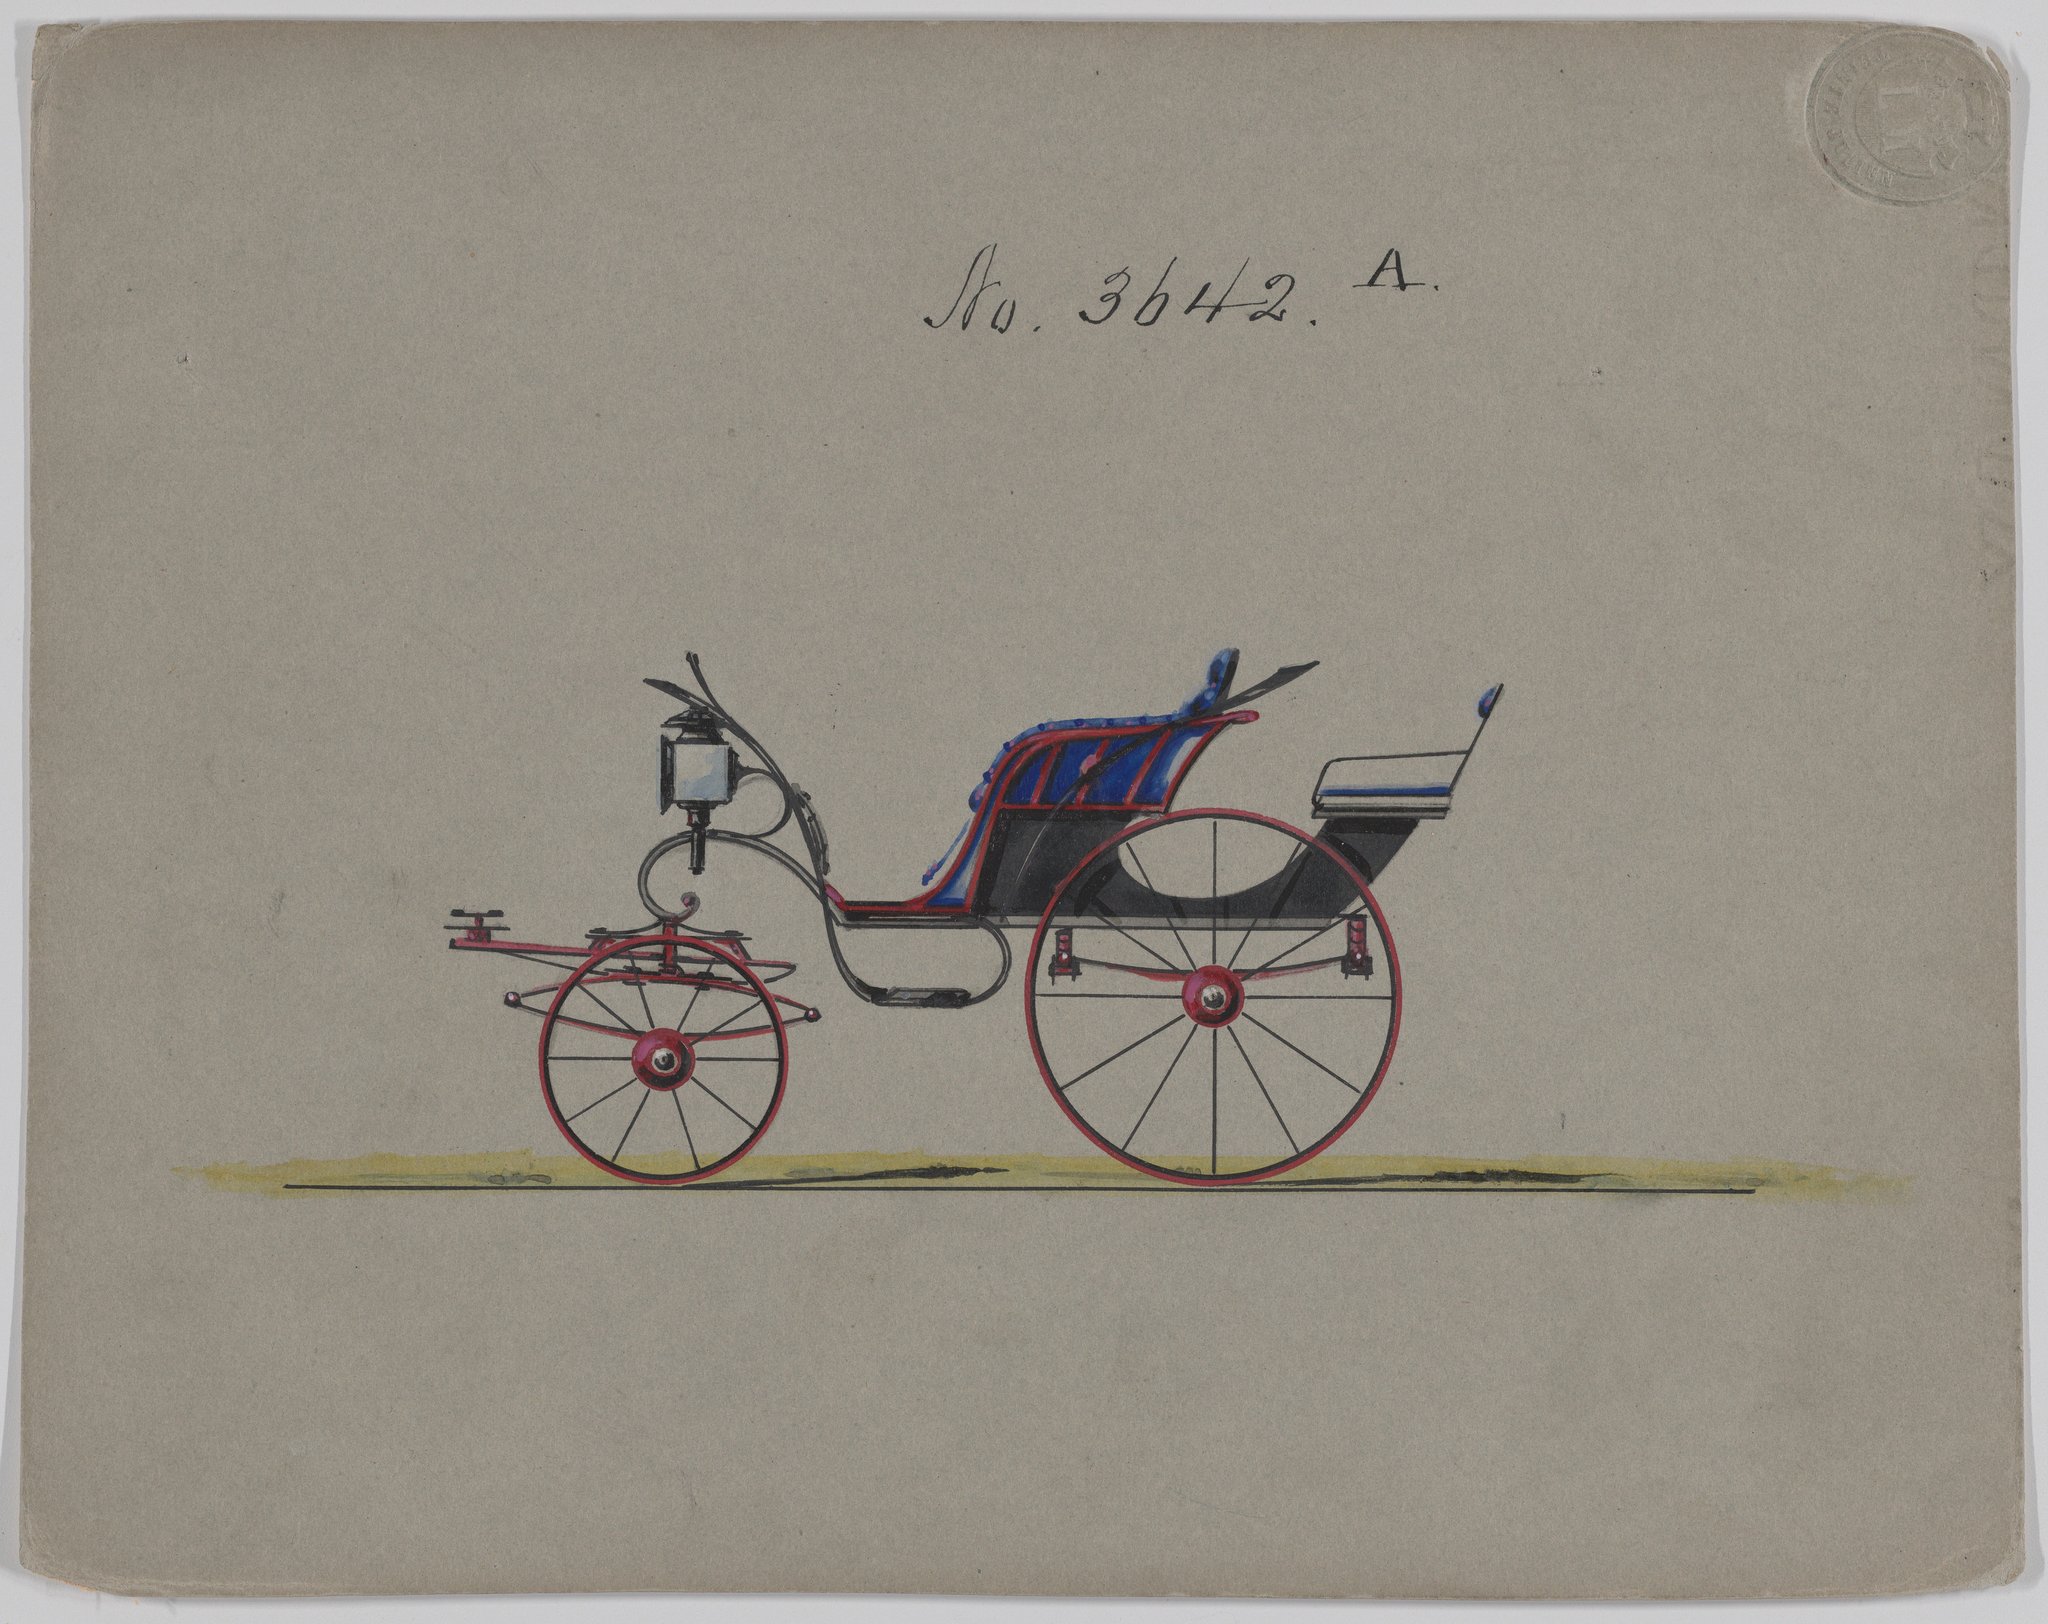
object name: drawing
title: Design for Pony Phaeton, no. 3642a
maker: brewster & co.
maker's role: manufacturer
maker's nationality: american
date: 1880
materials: gouache, gum arabic, ink, watercolor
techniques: pen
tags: carriages